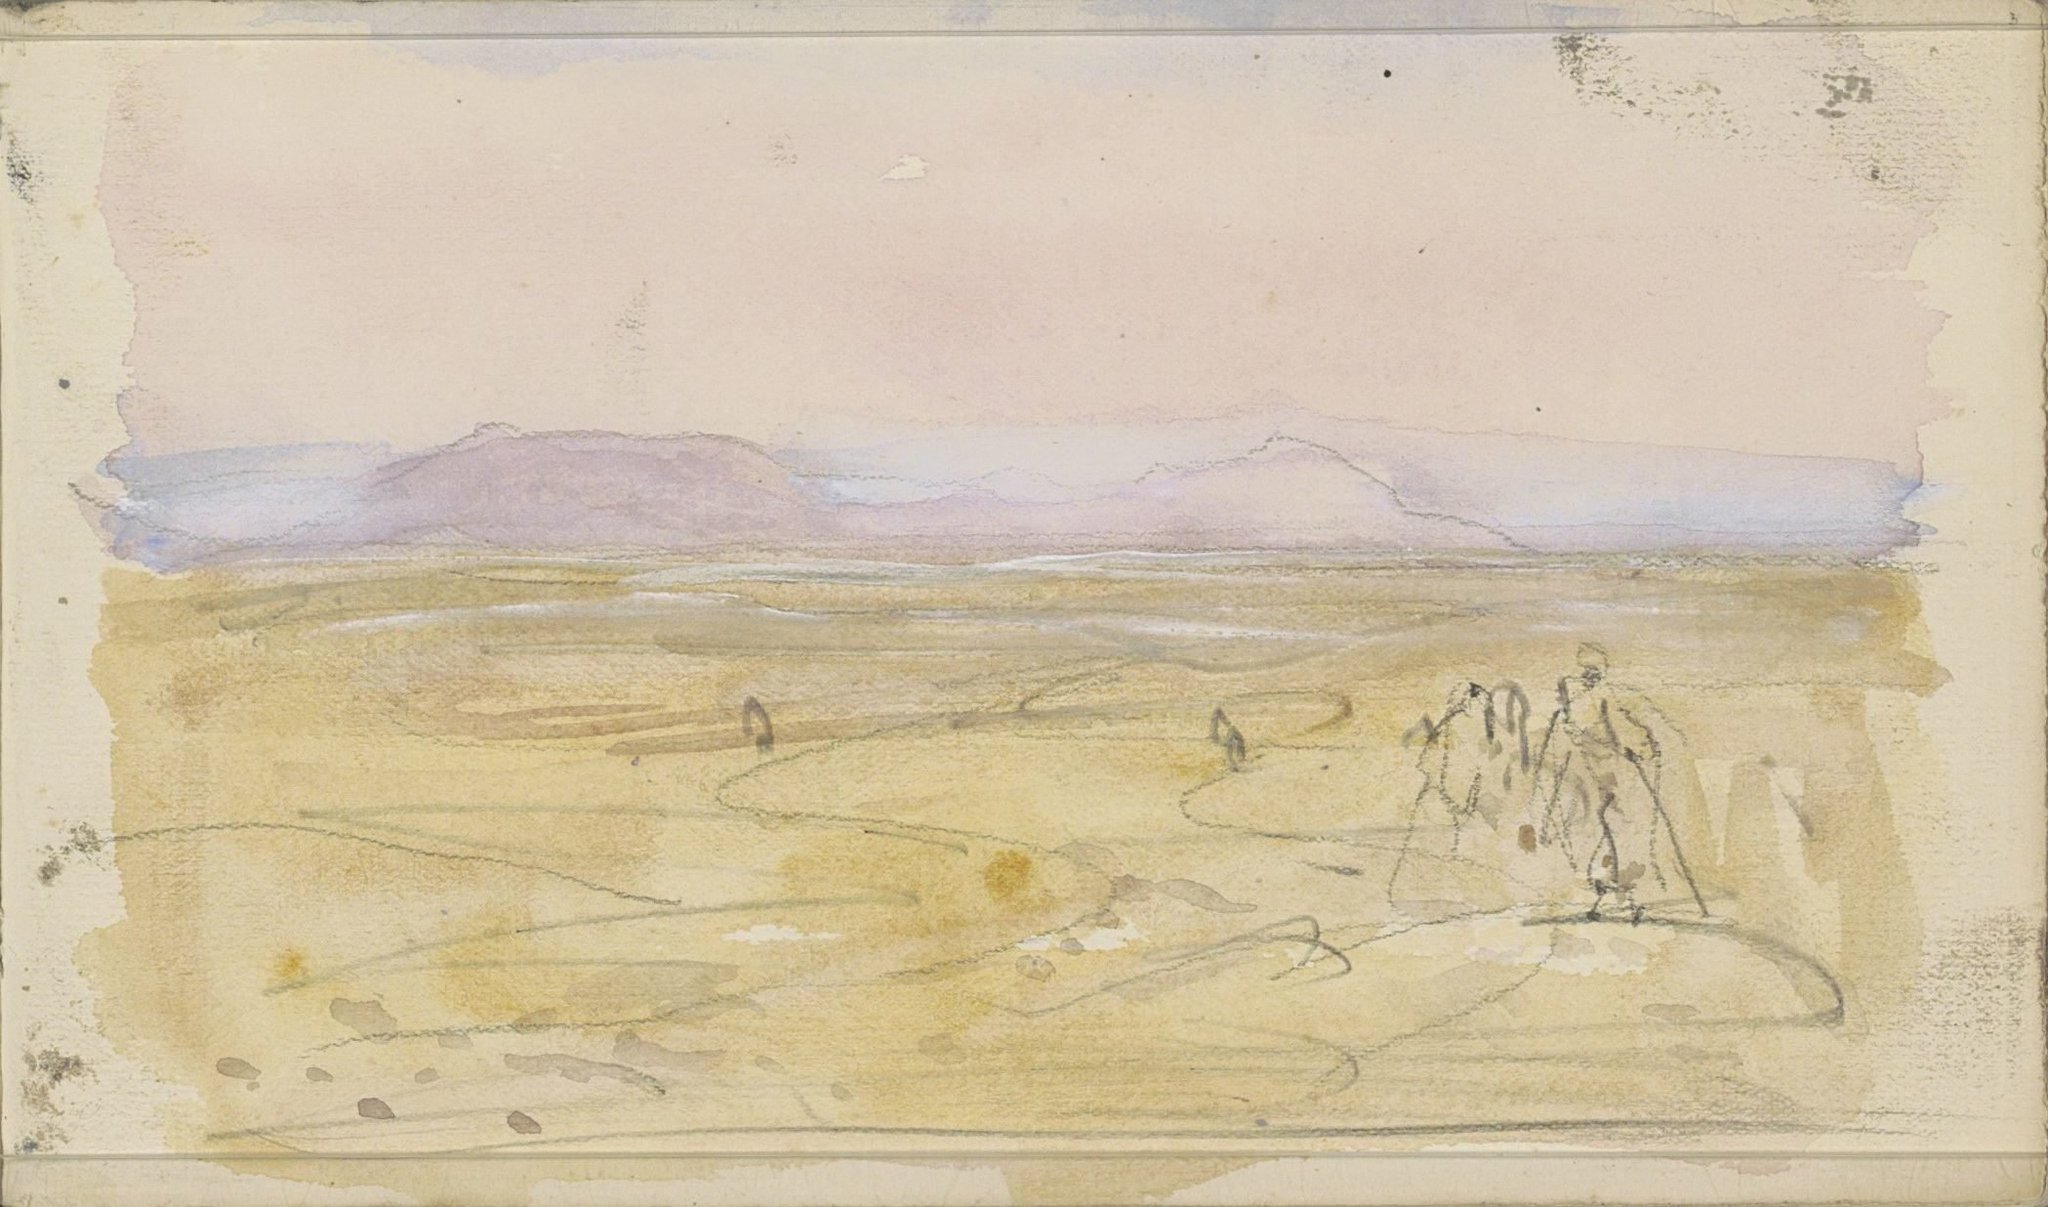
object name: sketchbook leaf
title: Woestijnlandschap met figuren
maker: marius bauer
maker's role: draughtsman, print maker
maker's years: 1867-1932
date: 1922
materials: paper, pencil, watercolor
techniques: brush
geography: algeria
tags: desert, landscapes (+ landscape with figures, staffage), mountains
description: Op de achtergrond vermoedelijk het Atlasgebergte. Pagina 3 uit een schetsboek met 31 bladen.